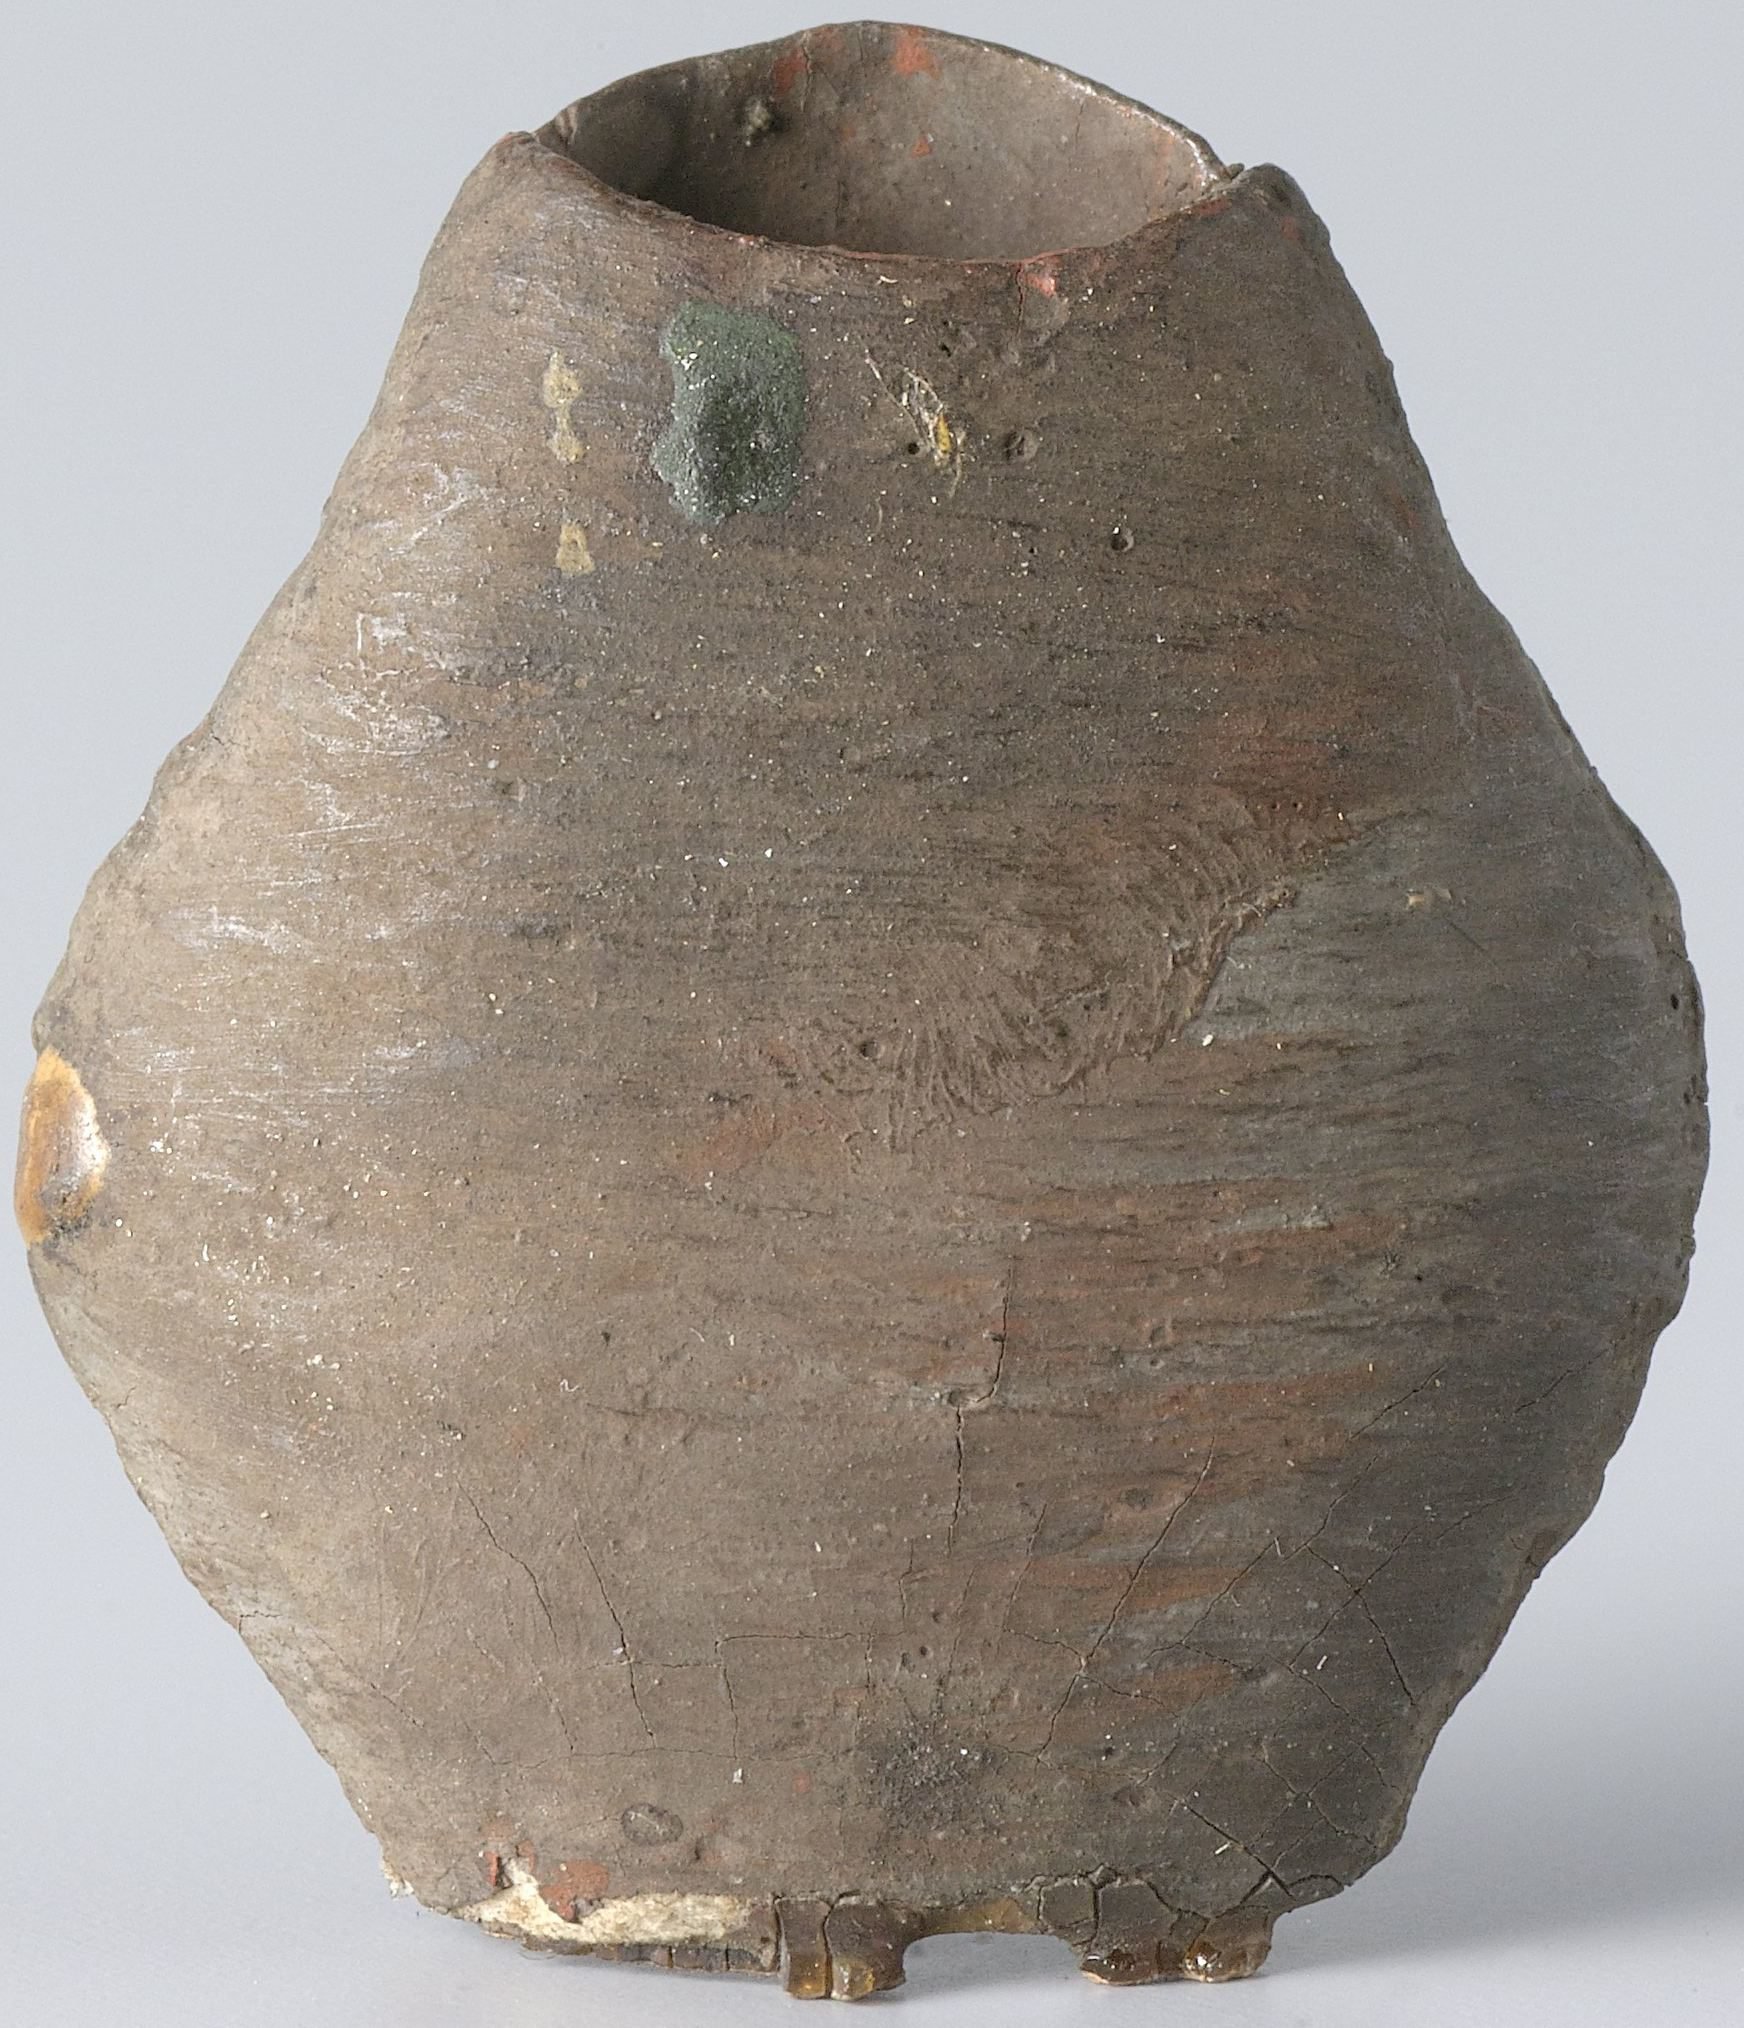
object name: jug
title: Een kruik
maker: gerrit schouten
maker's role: draughtsman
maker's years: 1779-1839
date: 1810-1839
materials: glue, paint, paper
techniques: modeling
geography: suriname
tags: suriname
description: Een los voorwerp uit een diorama van Gerrit Schouten, voorstellende een kruik of pot.